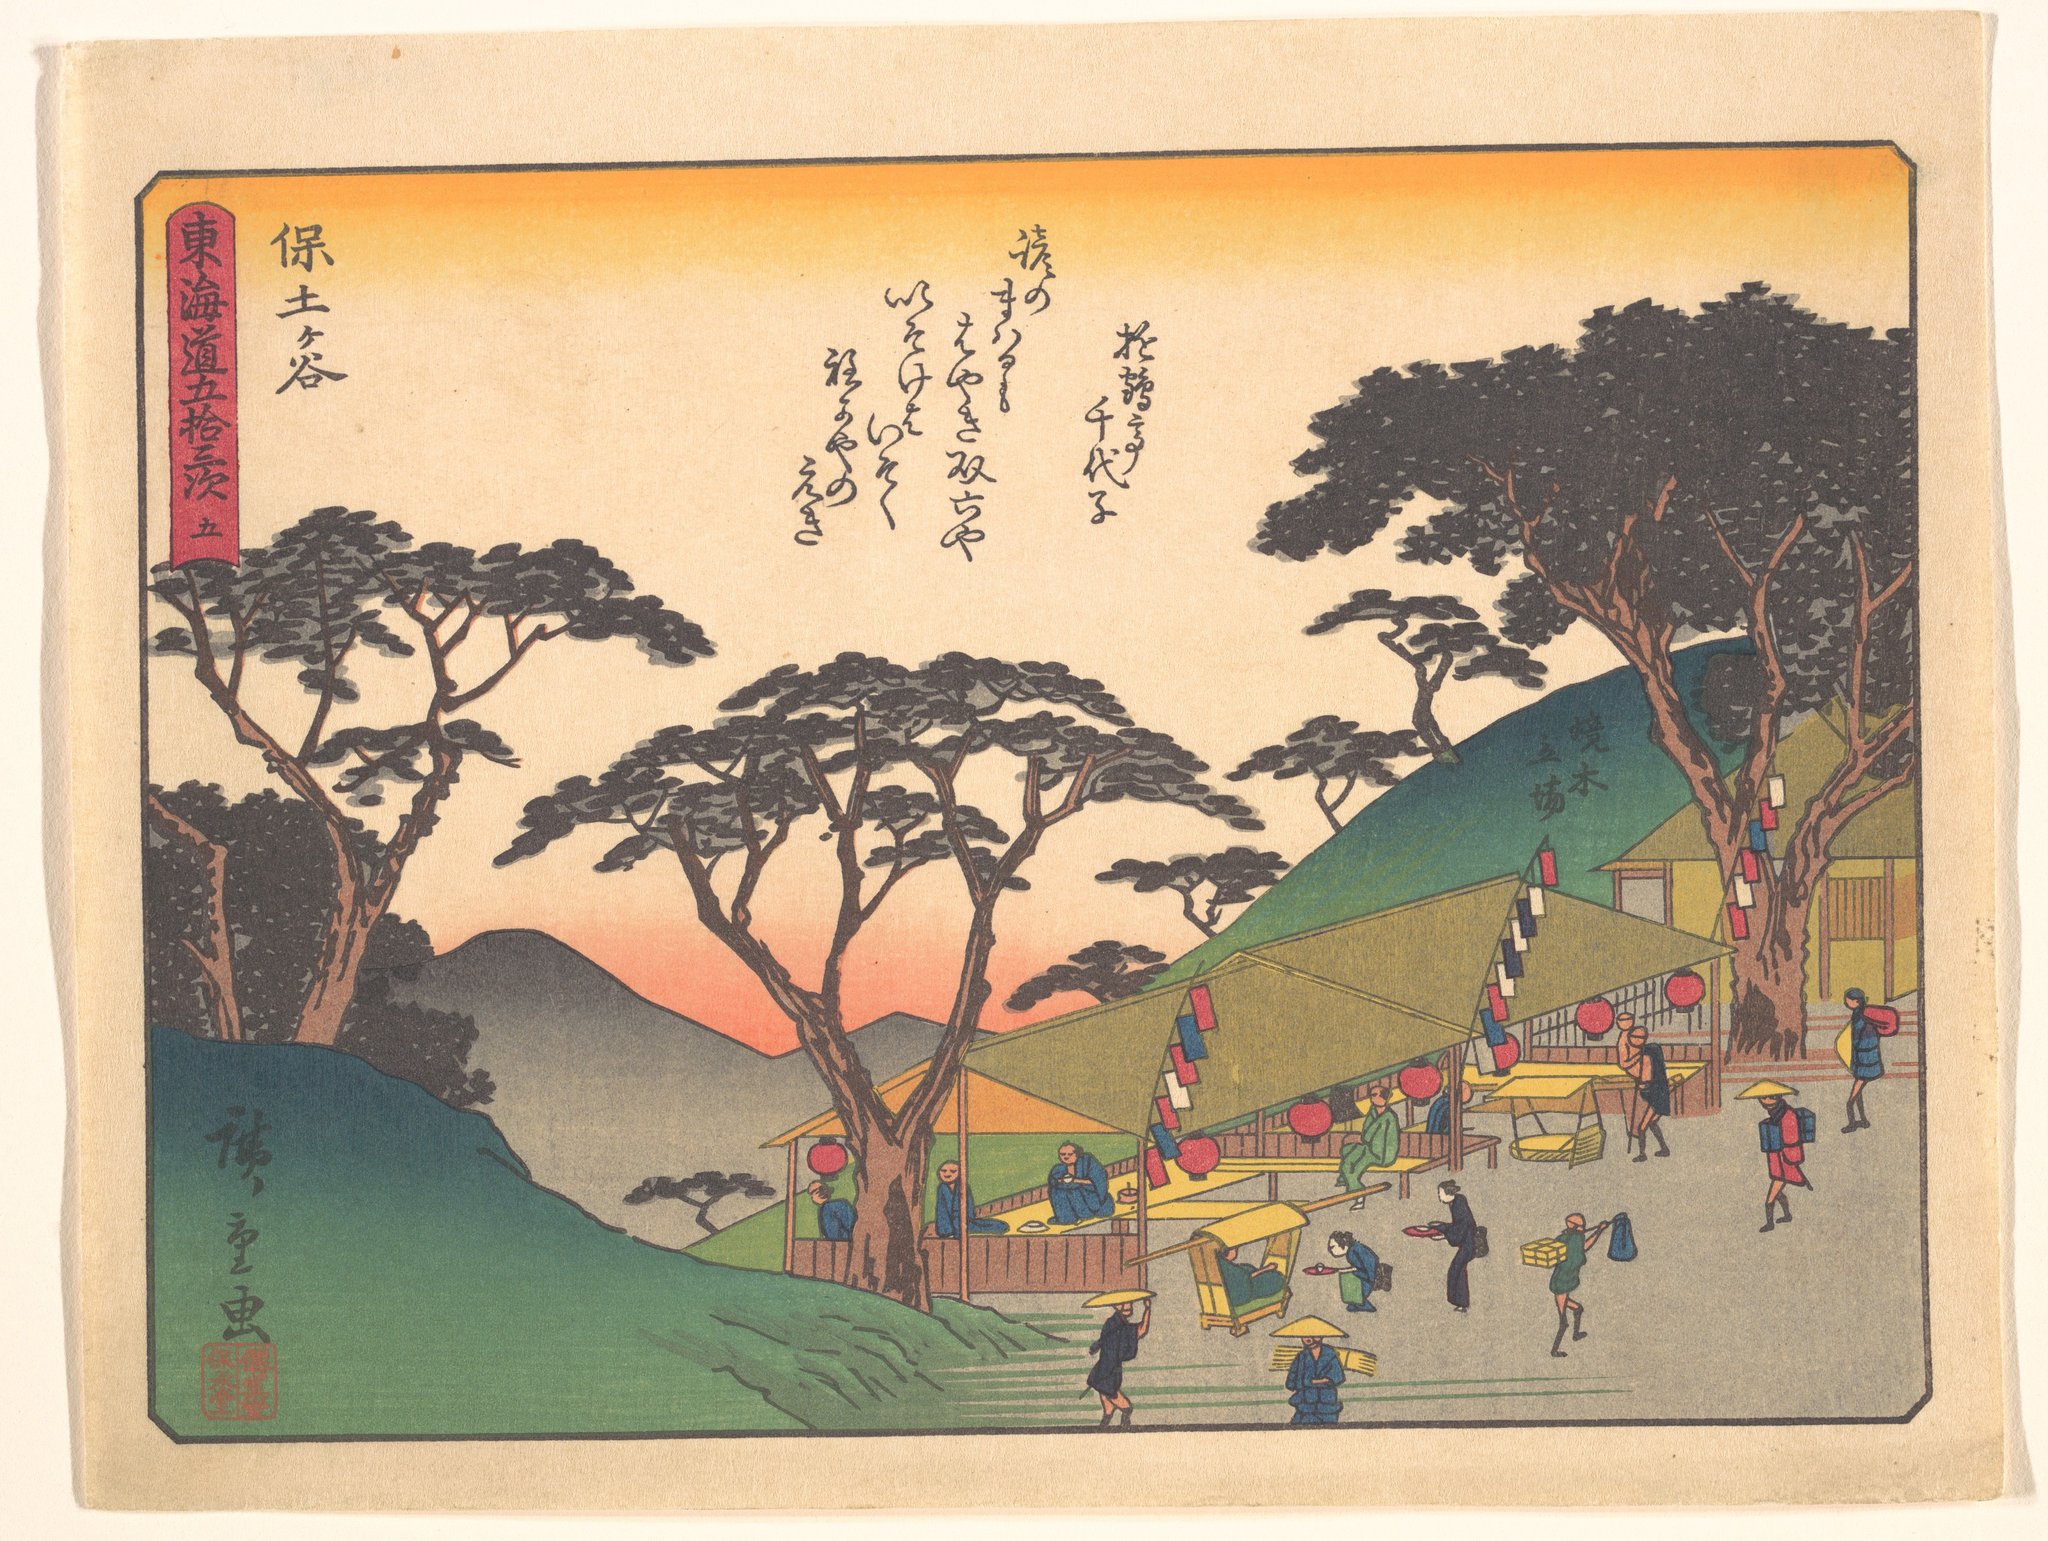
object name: print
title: 東海道五十三次 保土ヶ谷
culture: japanese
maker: utagawa hiroshige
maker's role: artist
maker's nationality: japanese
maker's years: 1797-1858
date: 1901-1933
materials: ink, paper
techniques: woodblock print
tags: human figures,houses,trees